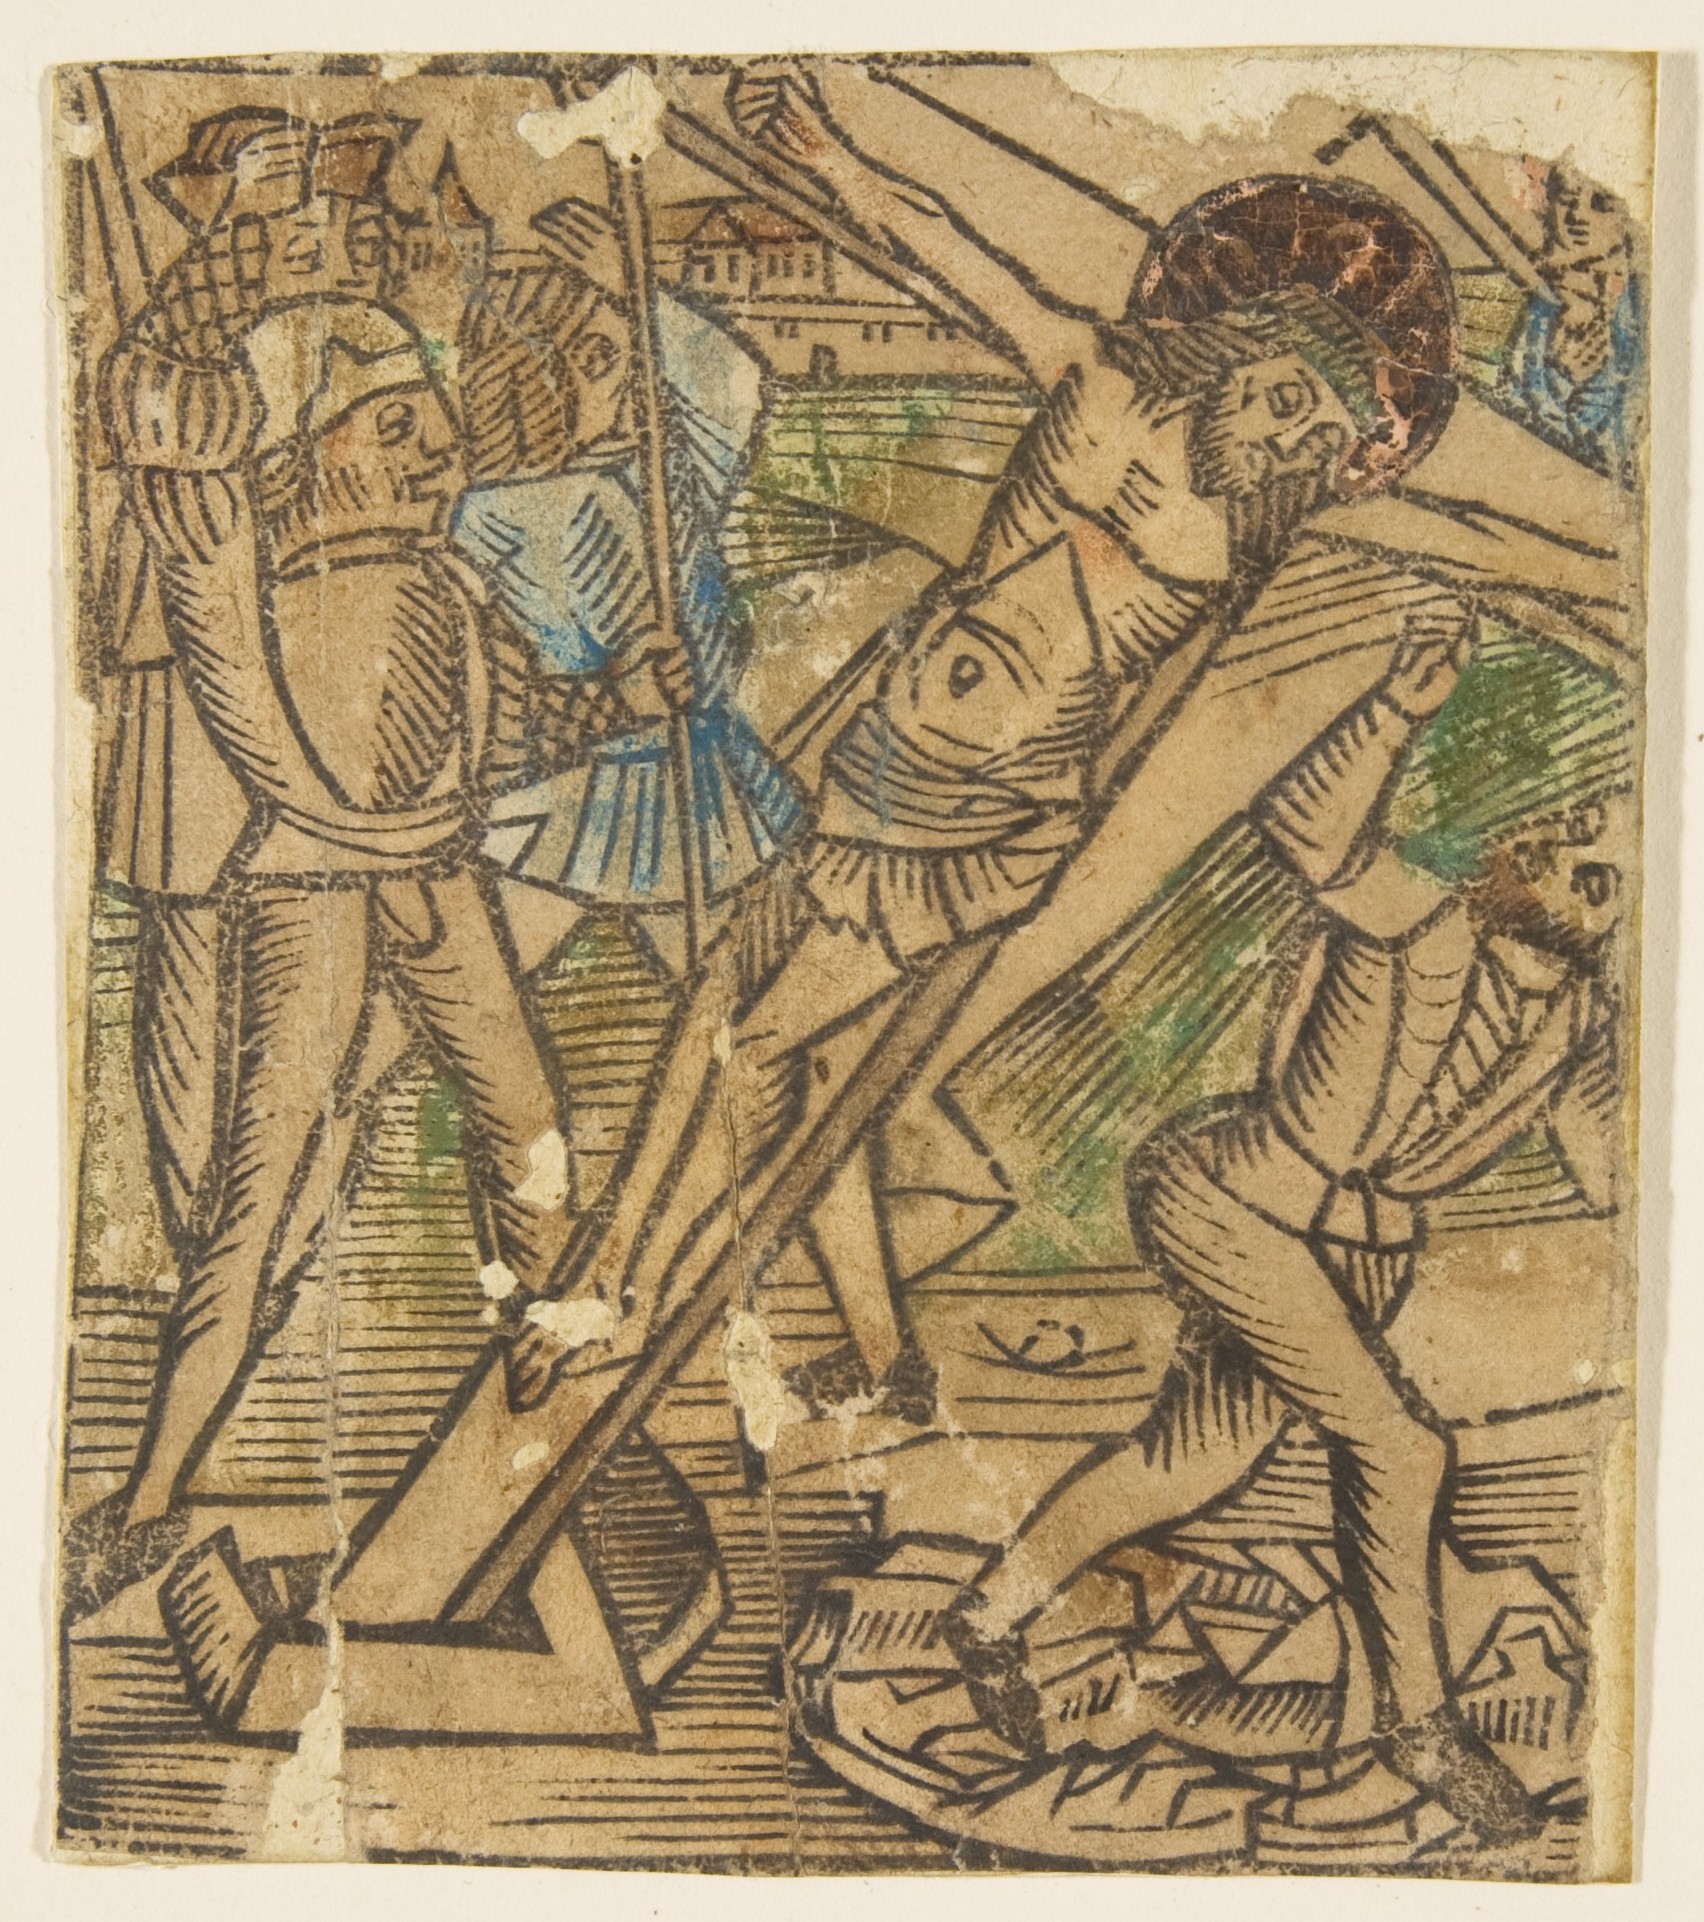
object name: print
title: One of the Seven Falls of Christ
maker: anonymous, german, 15th century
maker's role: artist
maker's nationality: german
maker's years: 1400-1500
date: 1401-1500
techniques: hand coloring, woodcut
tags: men,christ,crucifixion